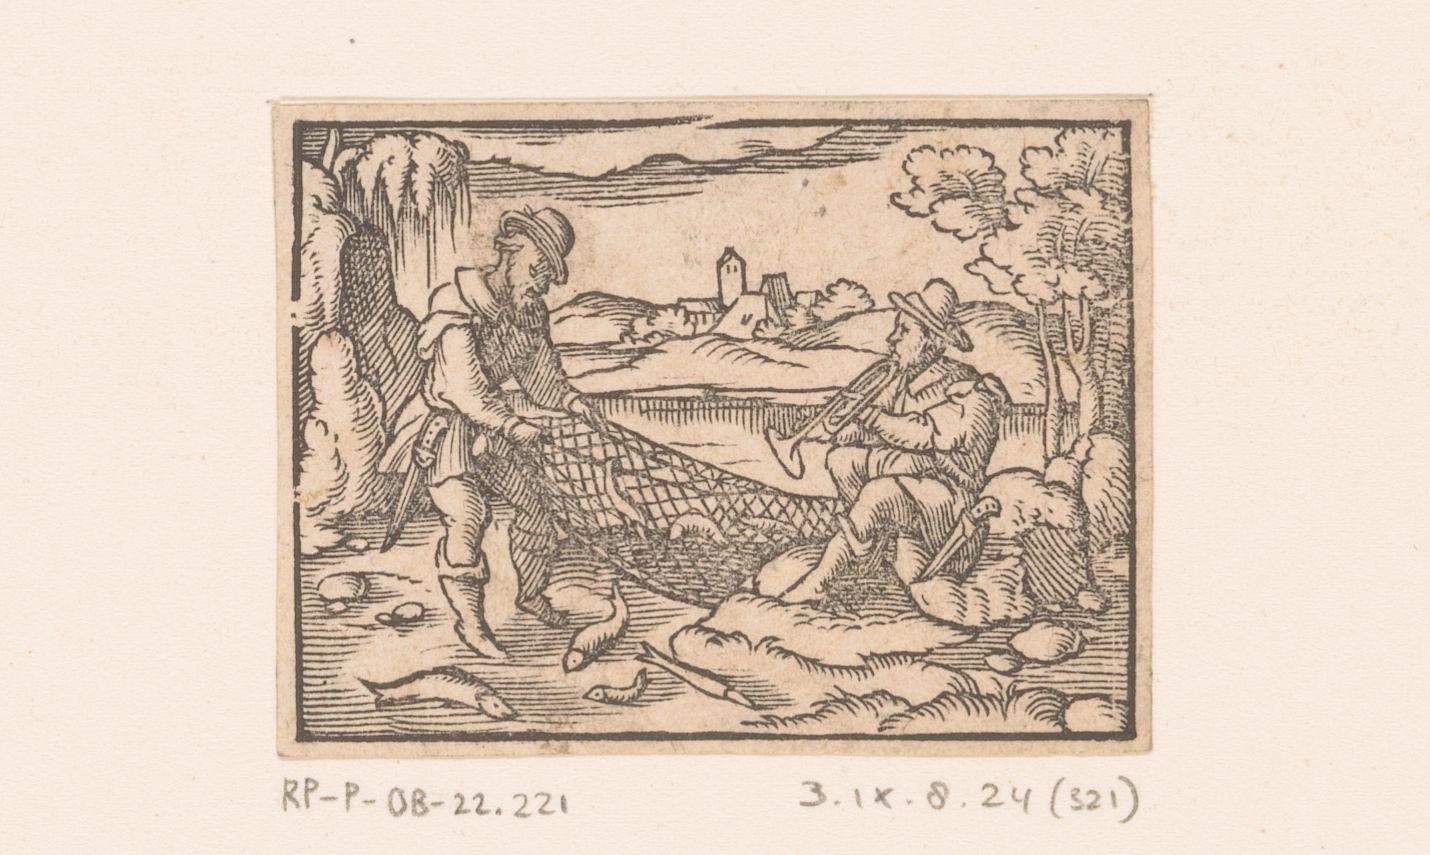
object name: print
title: Fabel van de musicerende visser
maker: virgilius solis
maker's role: draughtsman, print maker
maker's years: 1514-1562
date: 1566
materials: paper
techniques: woodcut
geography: nuremberg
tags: wind instruments - cc - out of doors, fisherman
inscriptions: number: ‘184’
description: Illustratie bij de Fabels van Aesopus, onder meer gebruikt voor de publicatie: Posthius, Johann. Aesopi Phrygis Fabulae. Frankfurt am Main: Sigmund Feyerabend, Georg Rab en erven Weigand Han, 1566.